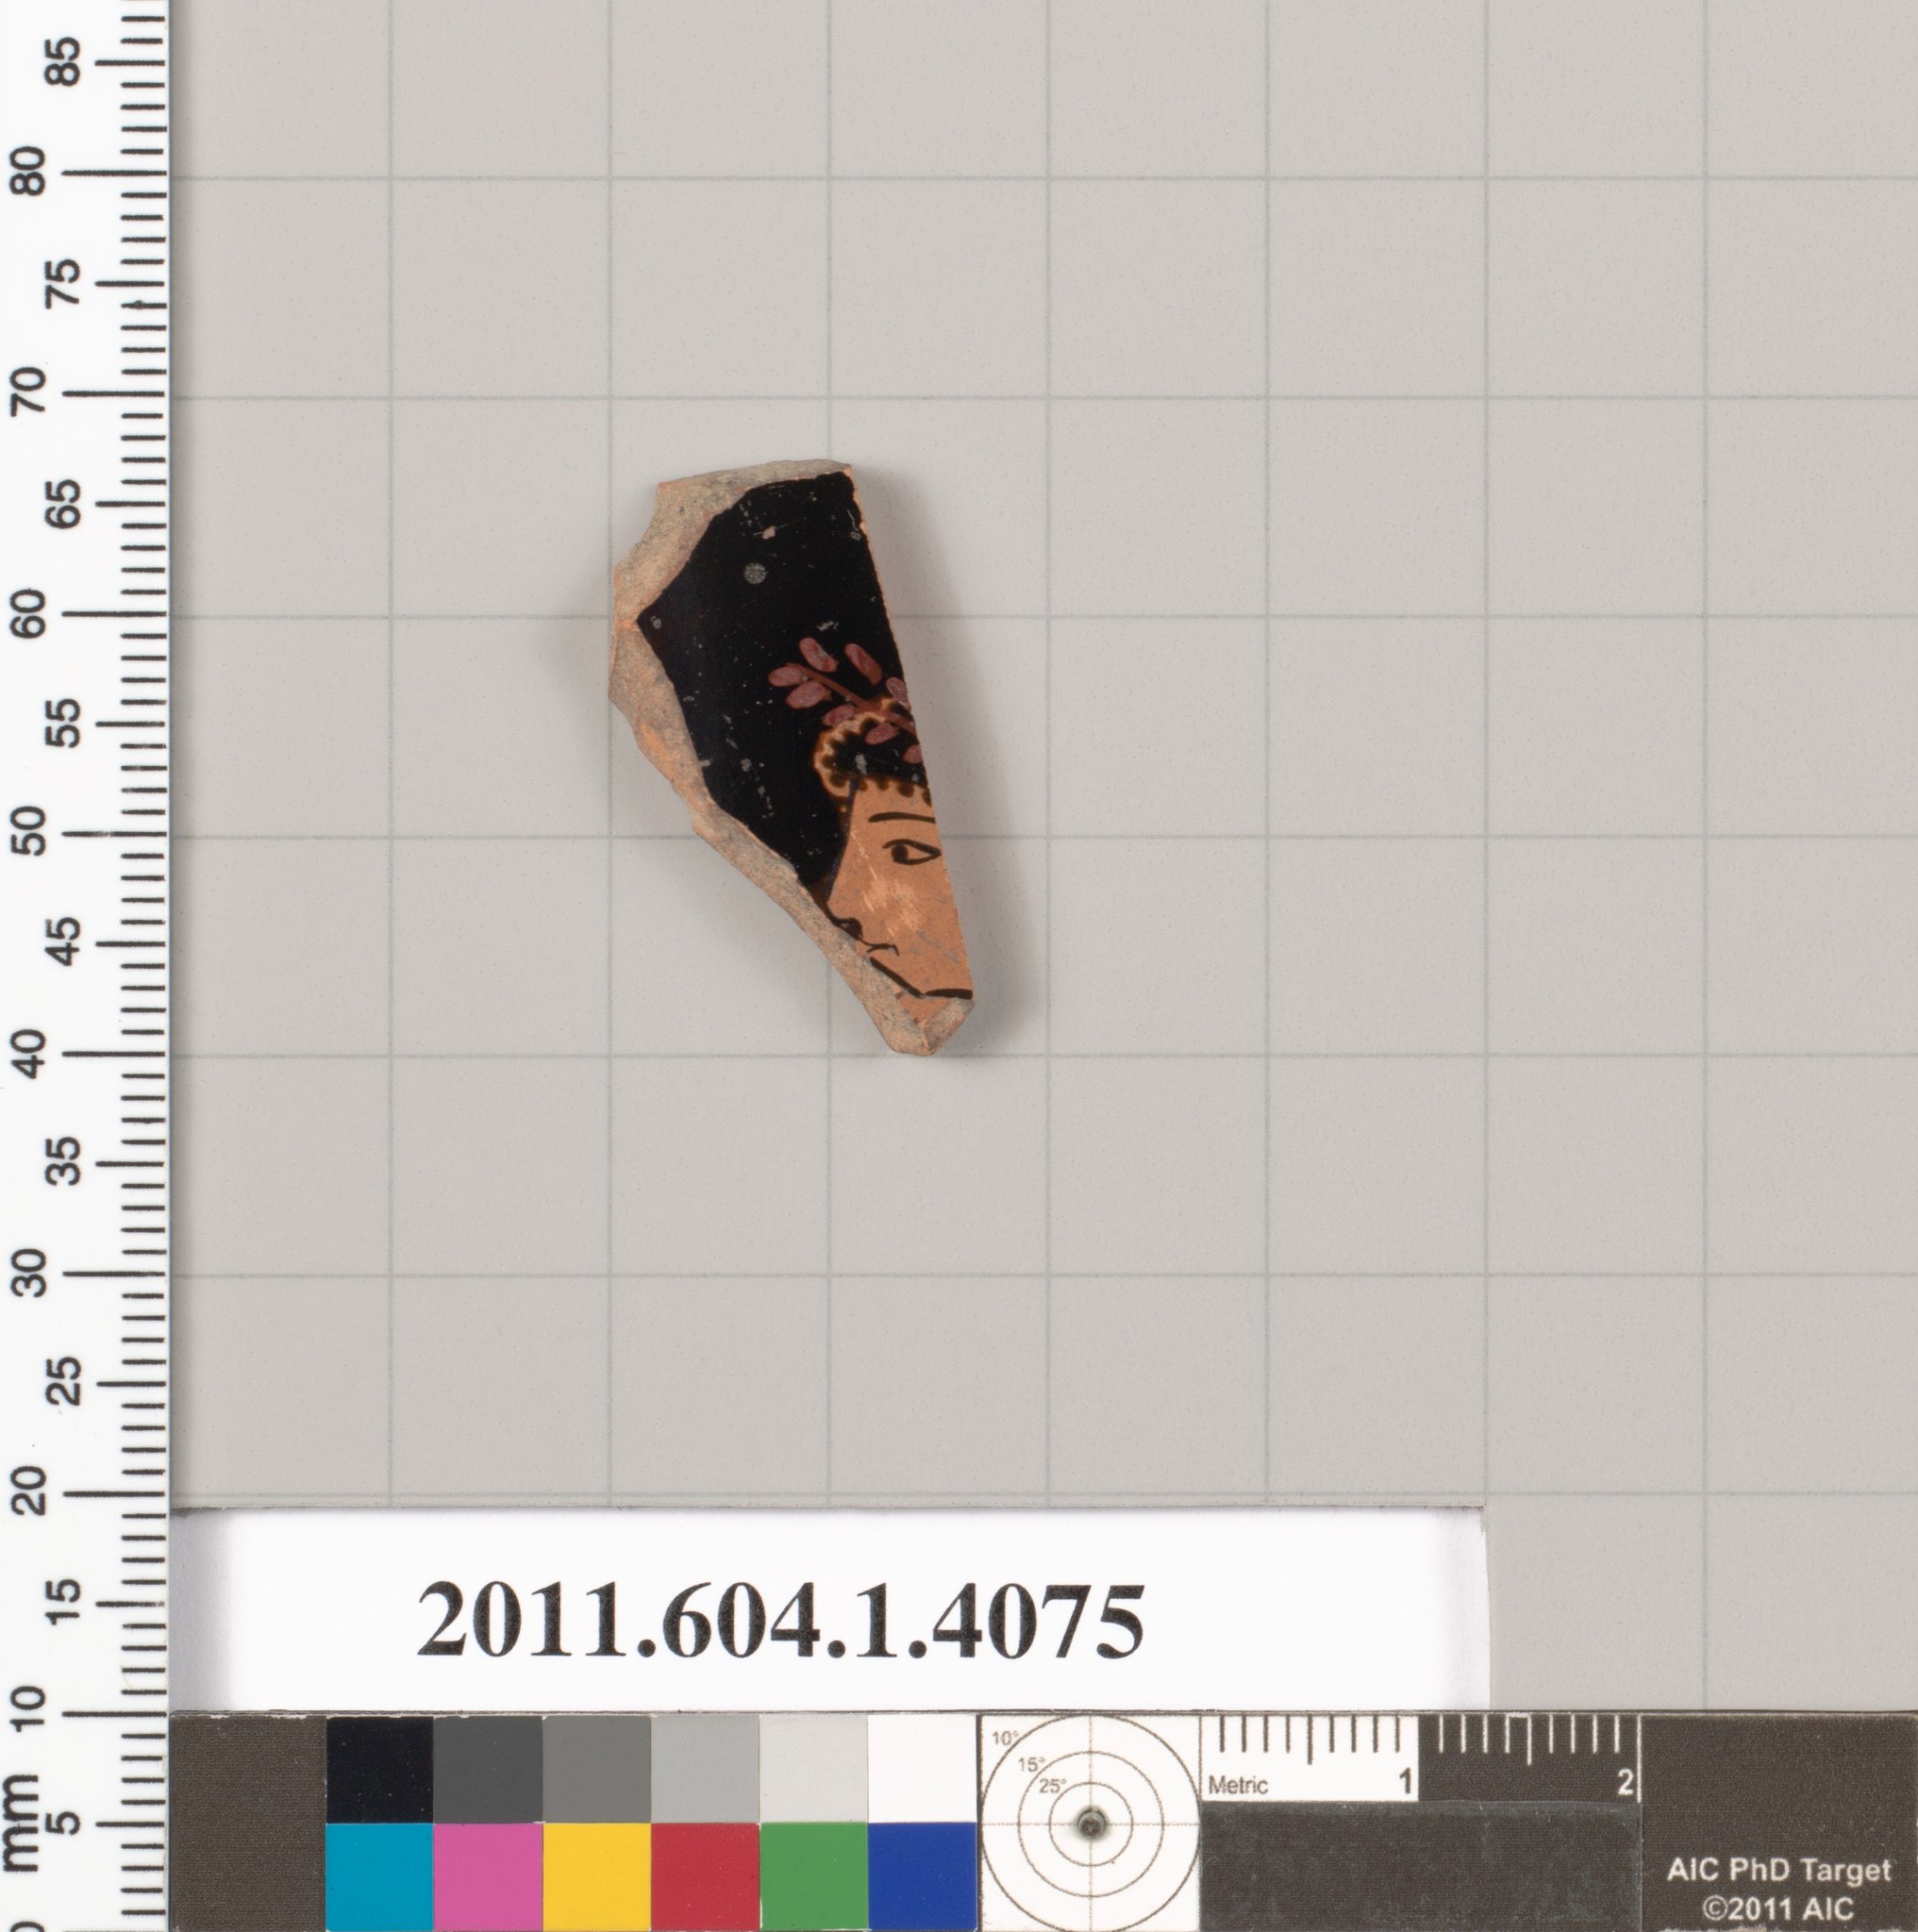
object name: kylix fragment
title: Terracotta fragment of a kylix (drinking cup)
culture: greek, attic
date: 490-470 BCE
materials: terracotta